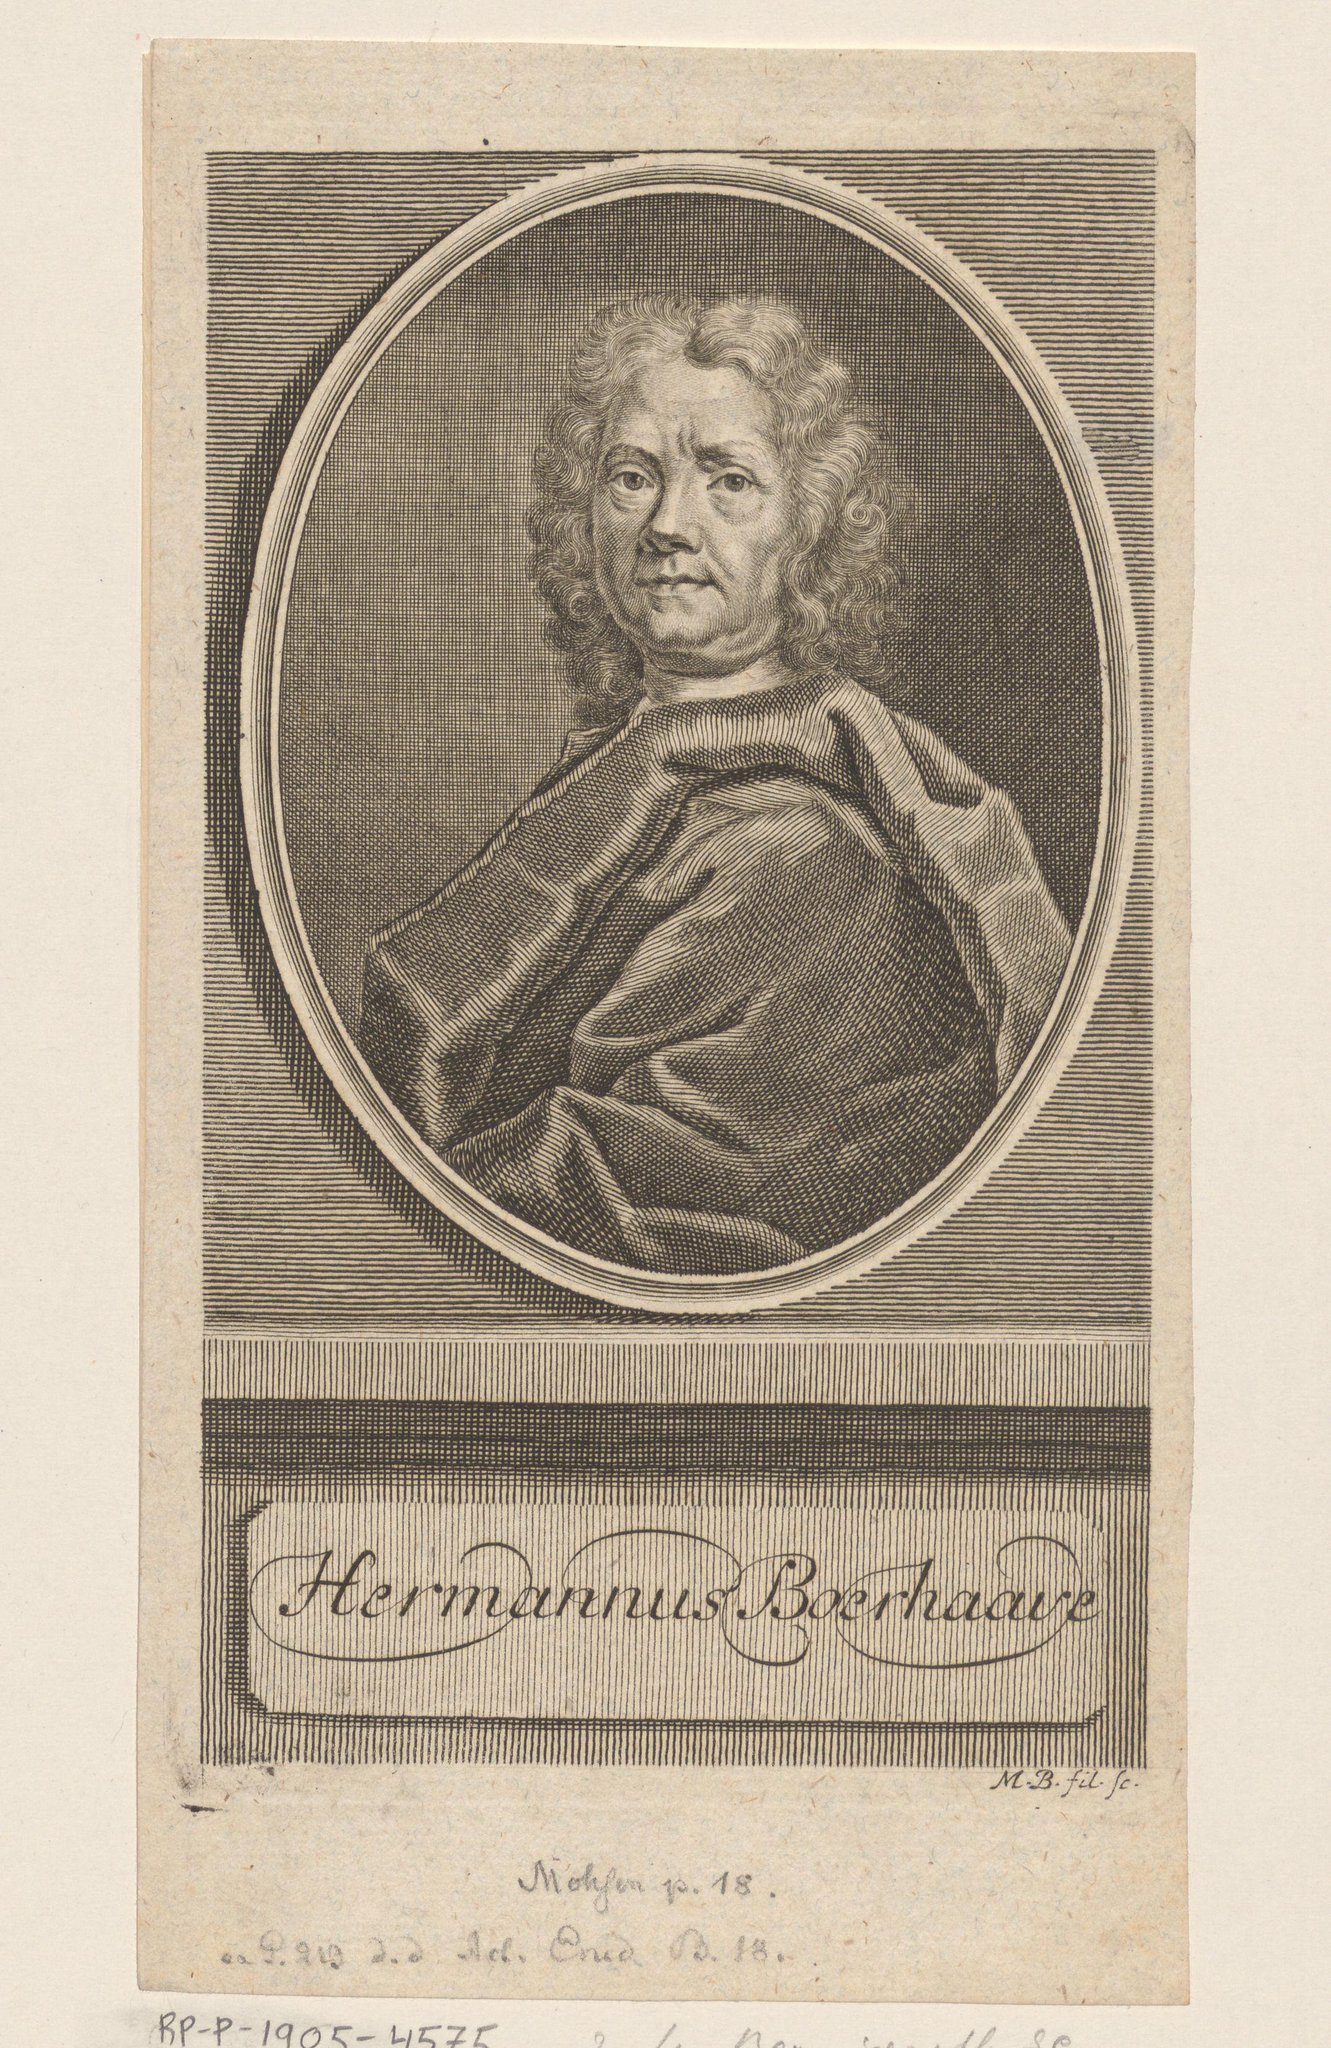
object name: print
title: Portret van Hermanus Boerhaave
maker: johann martin bernigeroth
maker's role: print maker, publisher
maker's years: 1713-1767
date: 1723-1767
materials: paper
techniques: engraving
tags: leiden, hermanus boerhaave, historical persons, physician, doctor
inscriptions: collector's mark: Lugt 2228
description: Prent waarschijnlijk uit: Deutsche Acta Eruditorum. Leipzig: Johann Gottlieb Gleditsch, 1737, dl. 213.